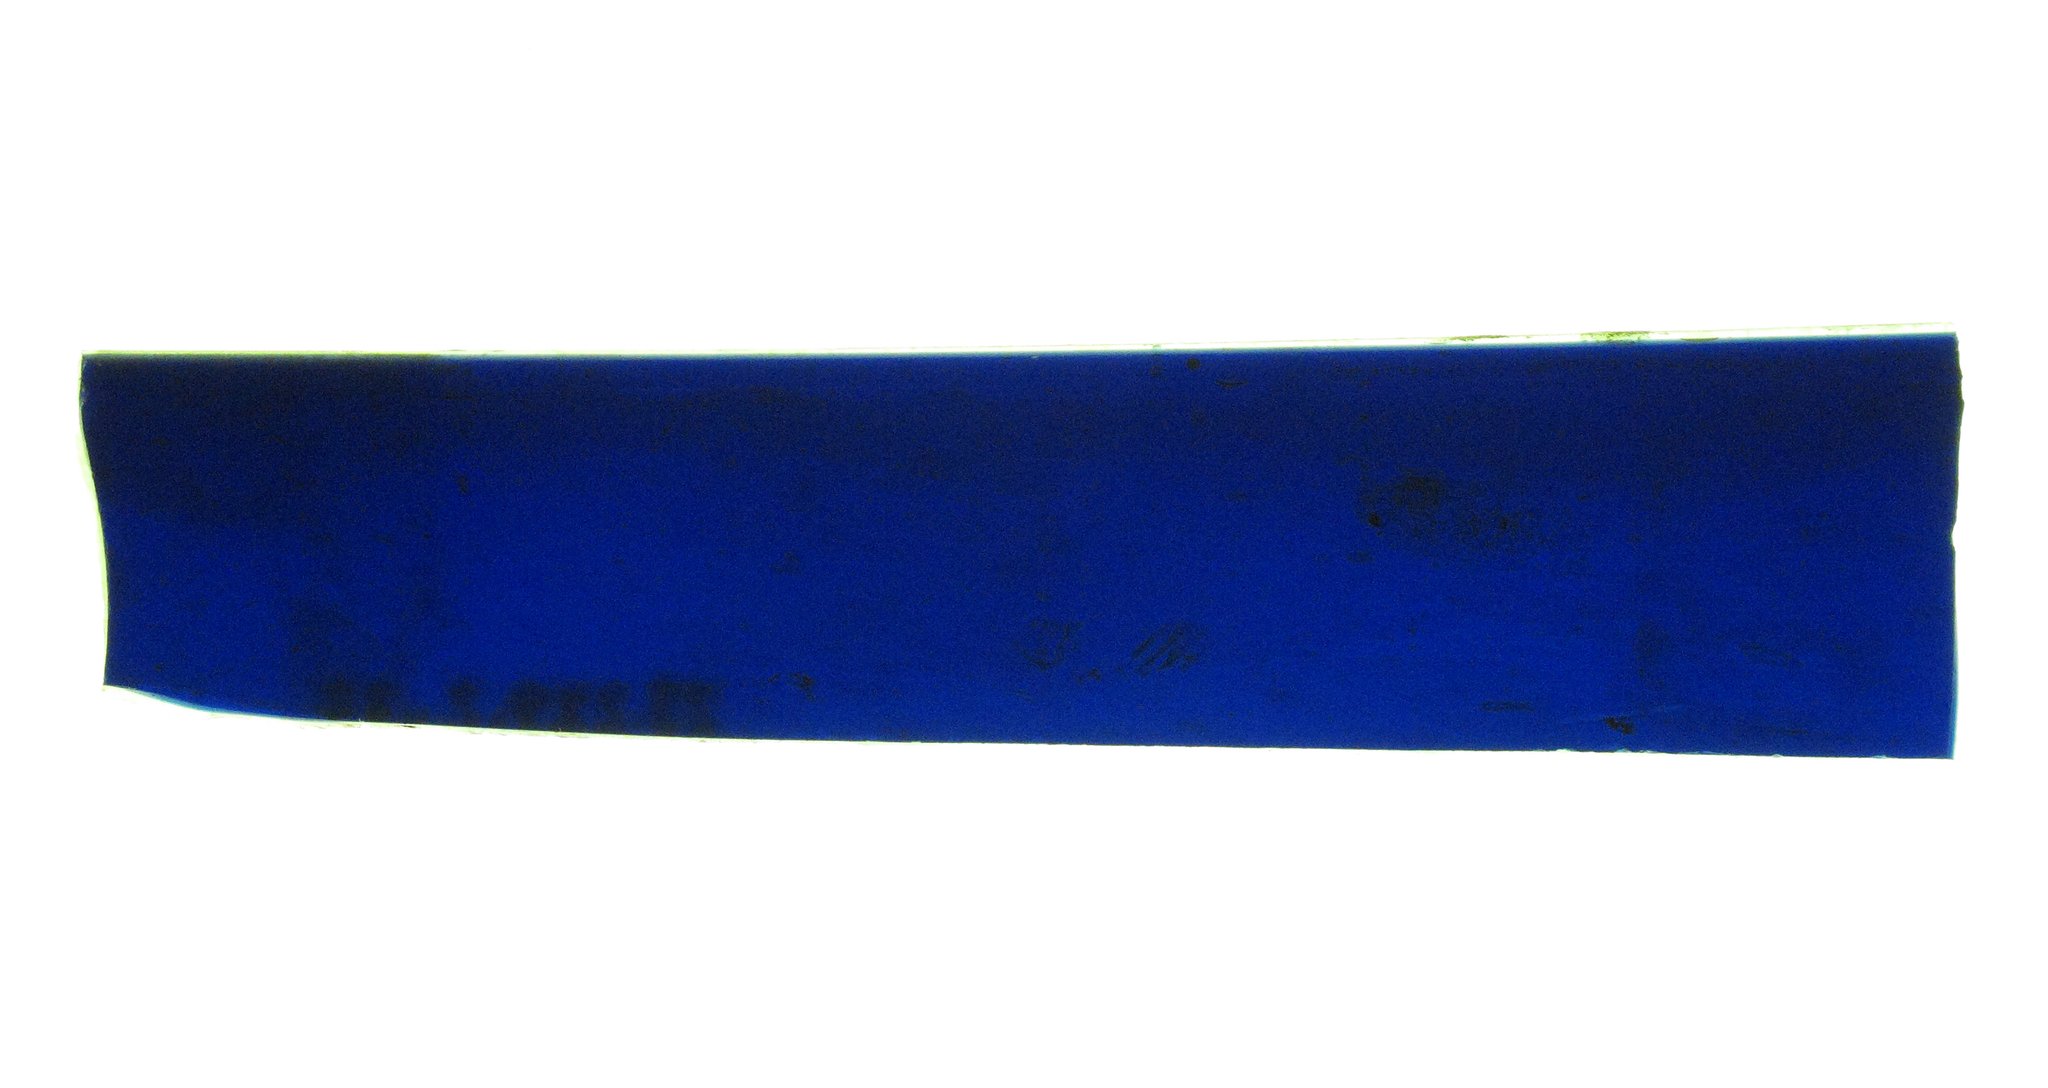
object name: fragment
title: Glass Fragment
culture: british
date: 1801-1900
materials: glass